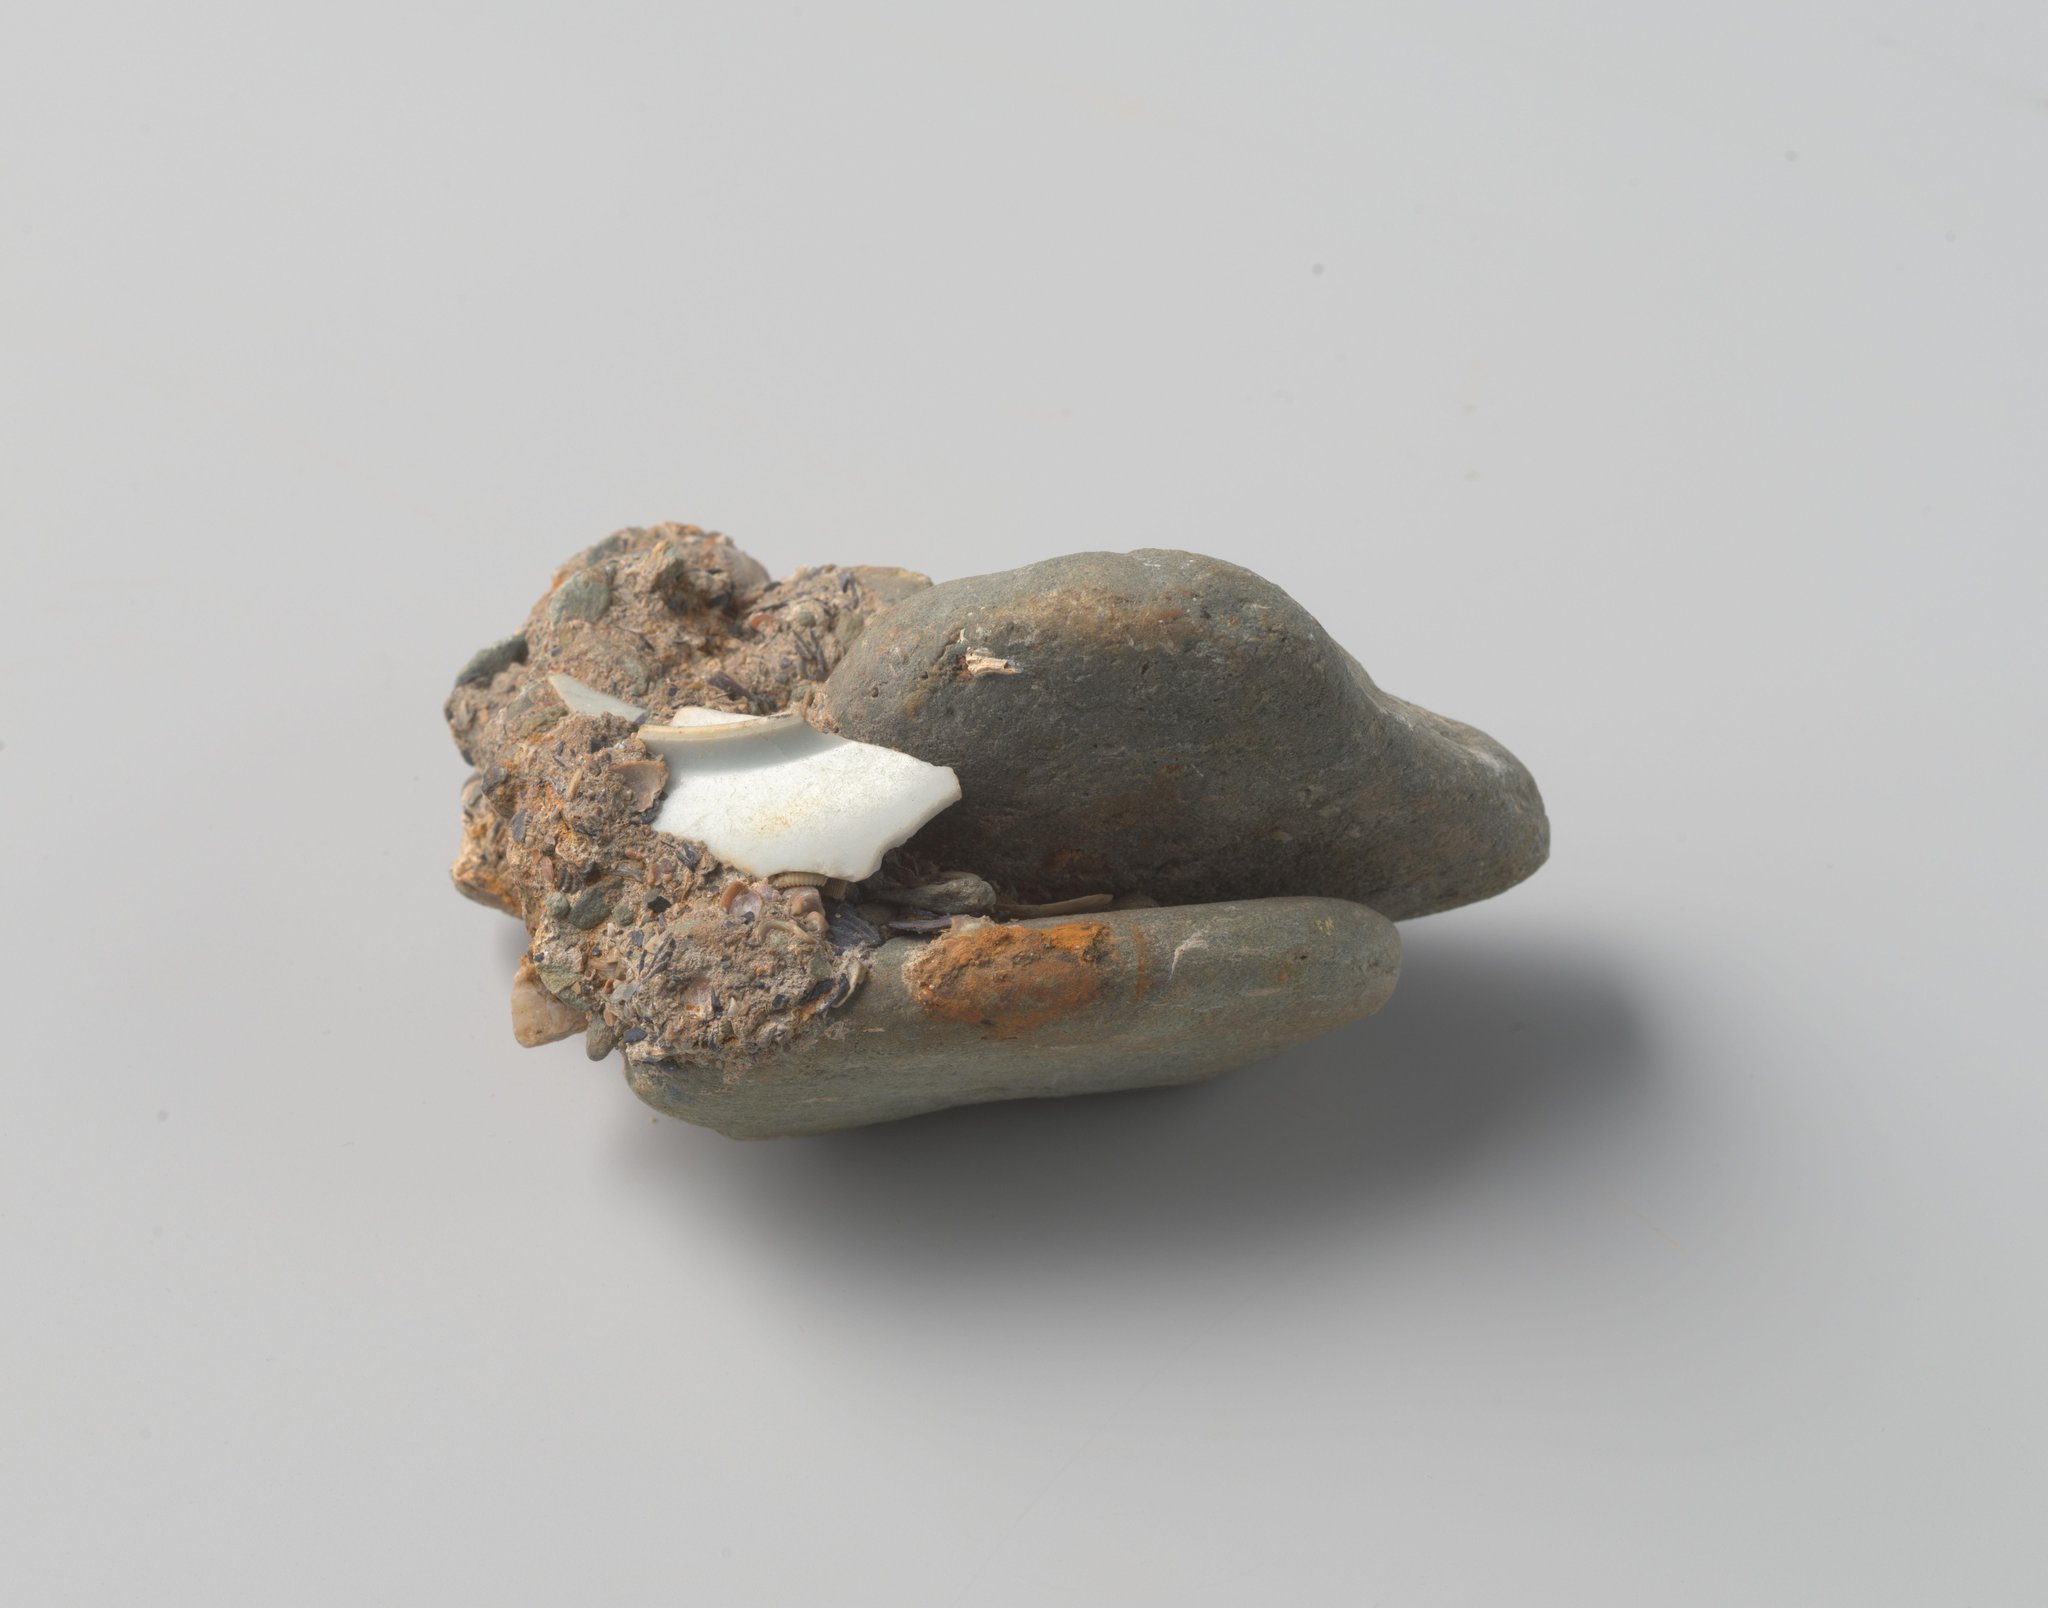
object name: steen objectnaam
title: Brok concretie met insluitsels van natuursteen en porselein uit het wrak van de Oostindiëvaarder Hollandia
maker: Anonymous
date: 1700-1743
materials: stone, porcelain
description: Brok concretie met insluitsels van natuursteen en porselein.